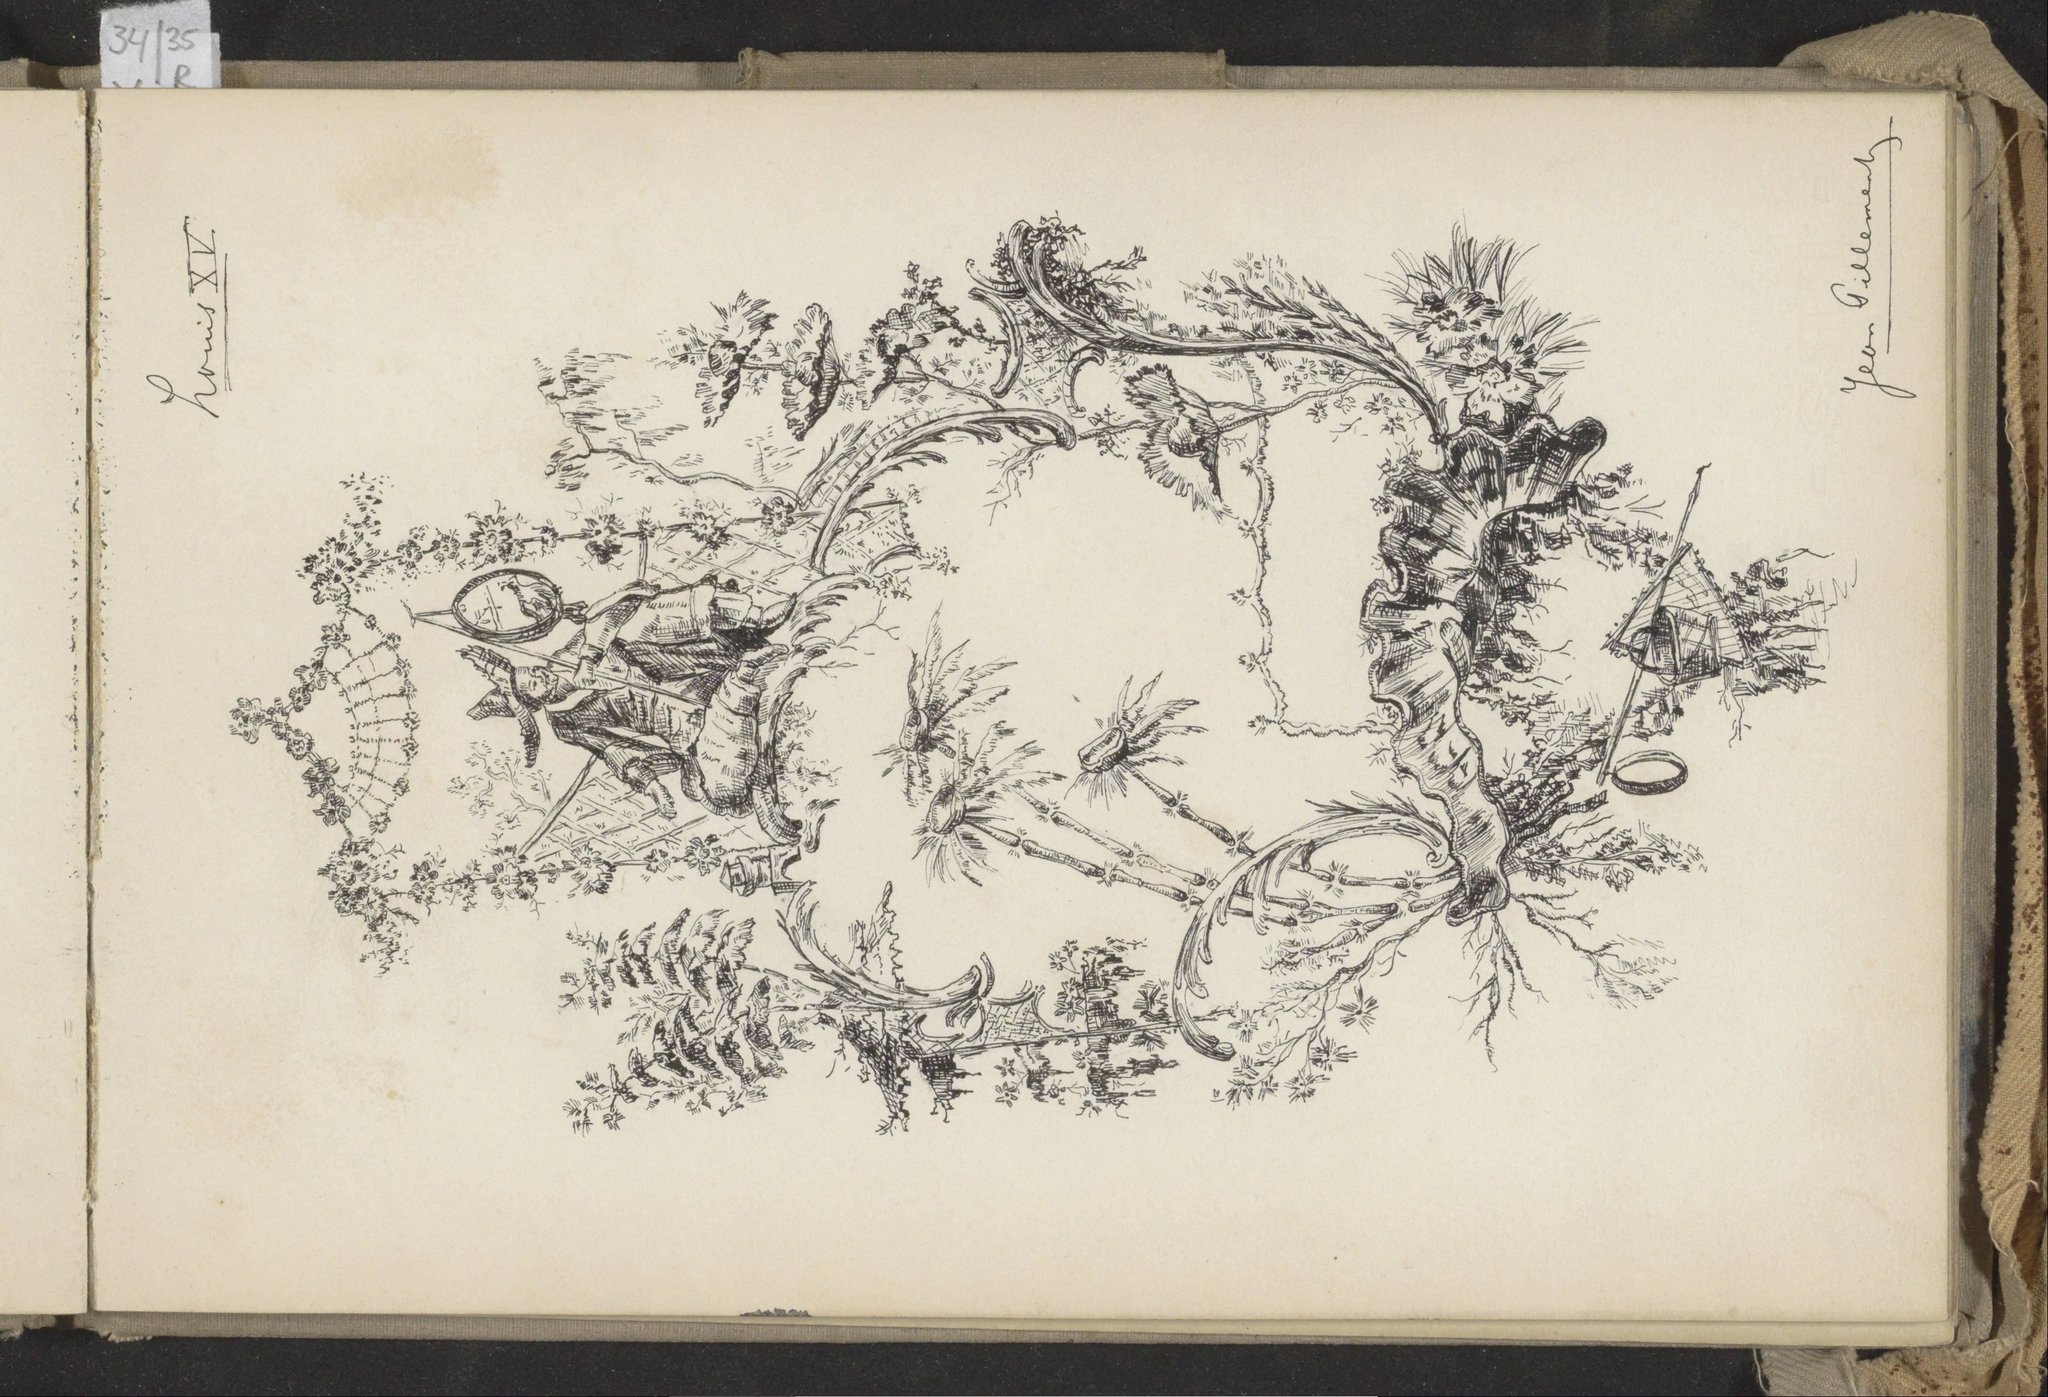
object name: sketchbook leaf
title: Chinoiserie uit de tijd van Louis XV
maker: johanna van de kamer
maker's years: 1873-1922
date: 1890-1922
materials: ink, paper, pencil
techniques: pen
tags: foliage, tendrils, branches ~ ornament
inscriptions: annotation: ‘Louis XV/ Jean Pillement’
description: Blad 30 recto uit een schetsboek met 49 bladen.